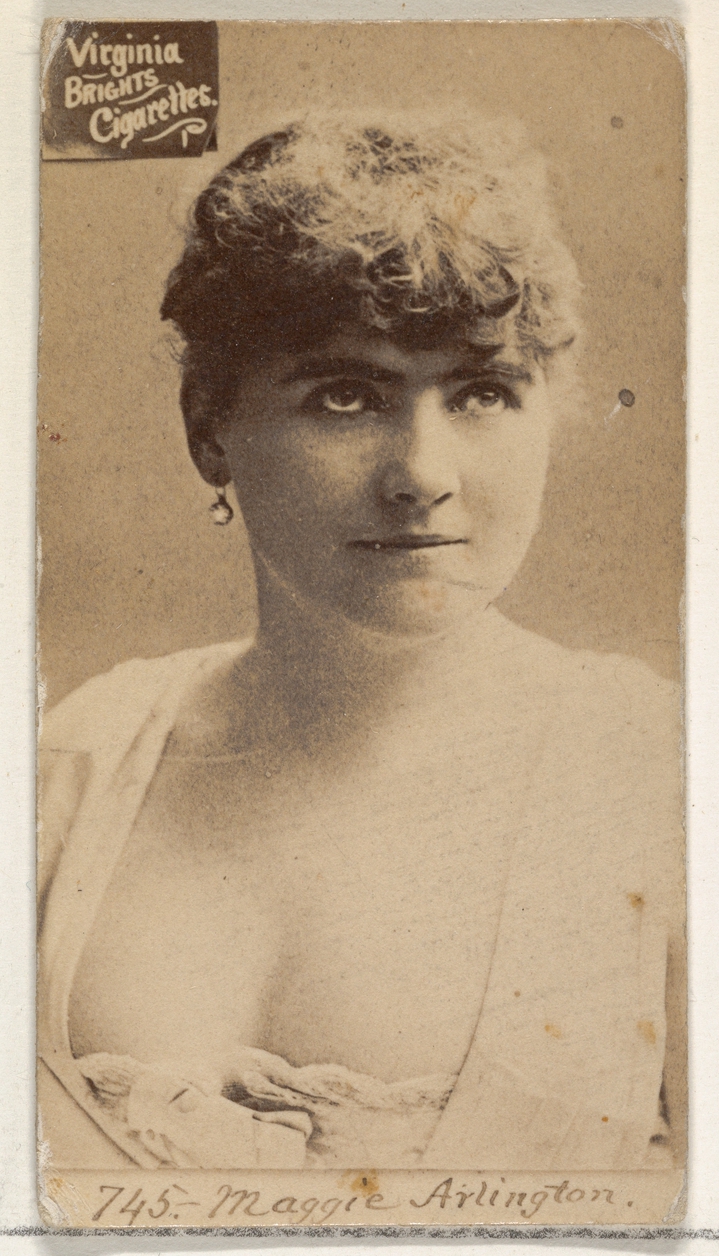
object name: photograph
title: Card 745, Maggie Arlington, from the Actors and Actresses series (N45, Type 2) for Virginia Brights Cigarettes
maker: allen & ginter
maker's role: publisher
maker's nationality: american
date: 1888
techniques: albumen silver print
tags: portraits,women,actresses